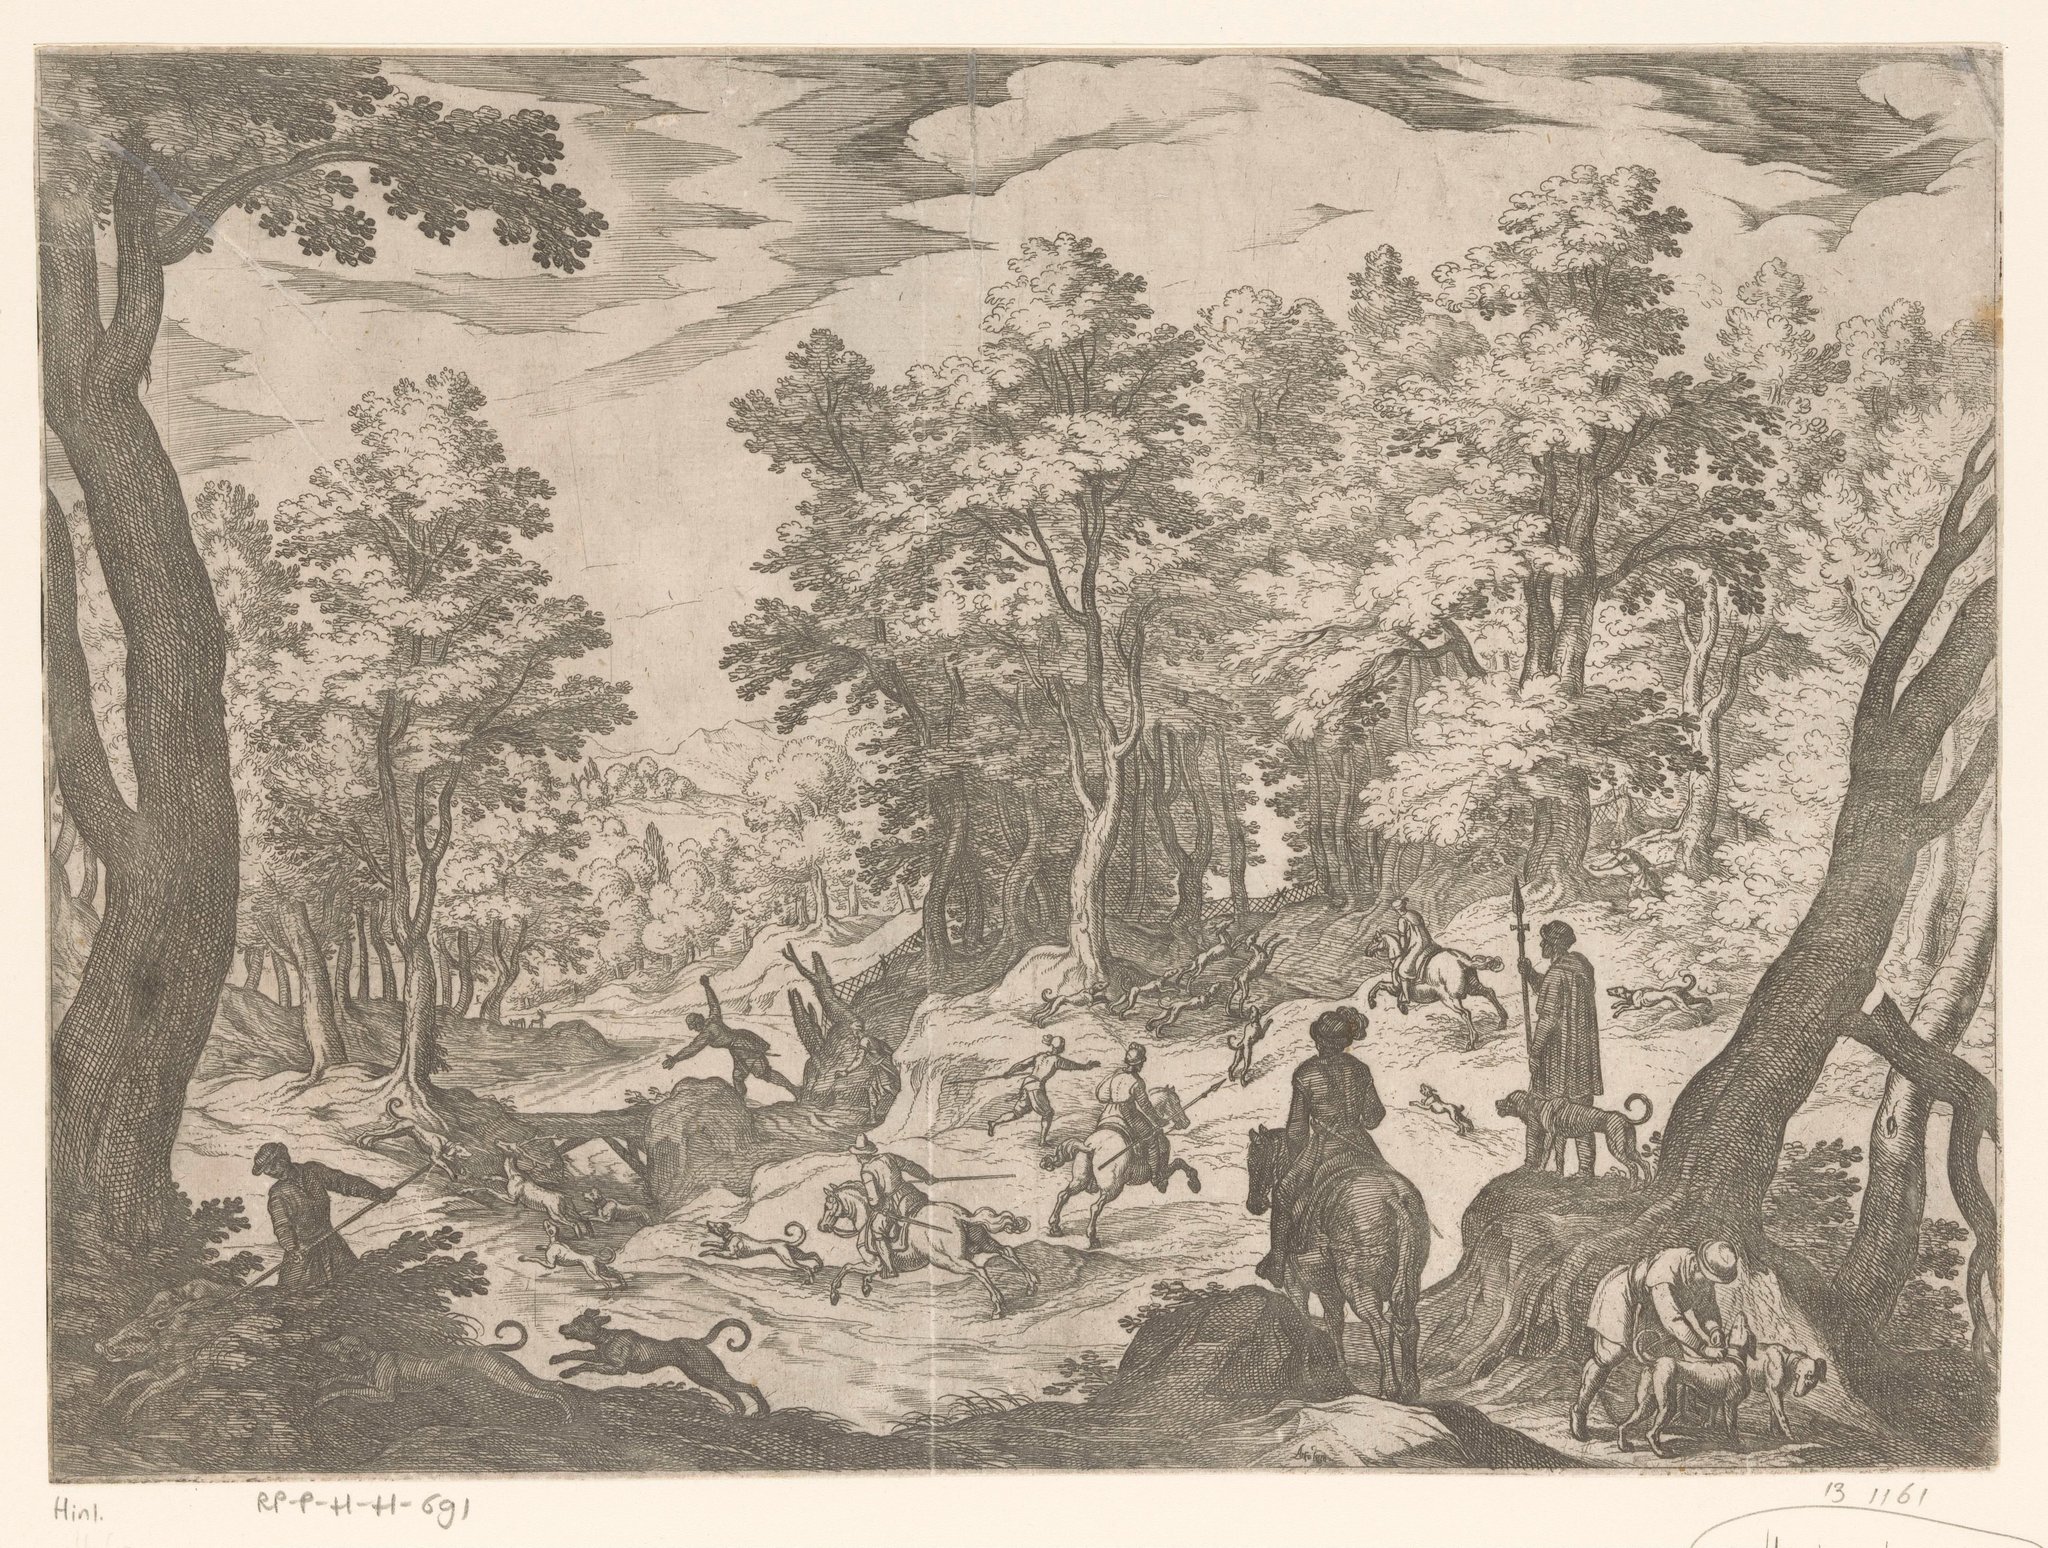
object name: print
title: Jachtscènes (deel 8)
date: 1599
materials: paper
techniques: etching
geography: italy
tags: stag-hunting, boar-hunting, hunter, hunters hunting (n.b.: in 1988-1990 this notation denoted the concept of 43c11421 'hunters resting during the hunt')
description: Deze prent maakt deel uit van een reeks van vier prenten met jachtscènes.